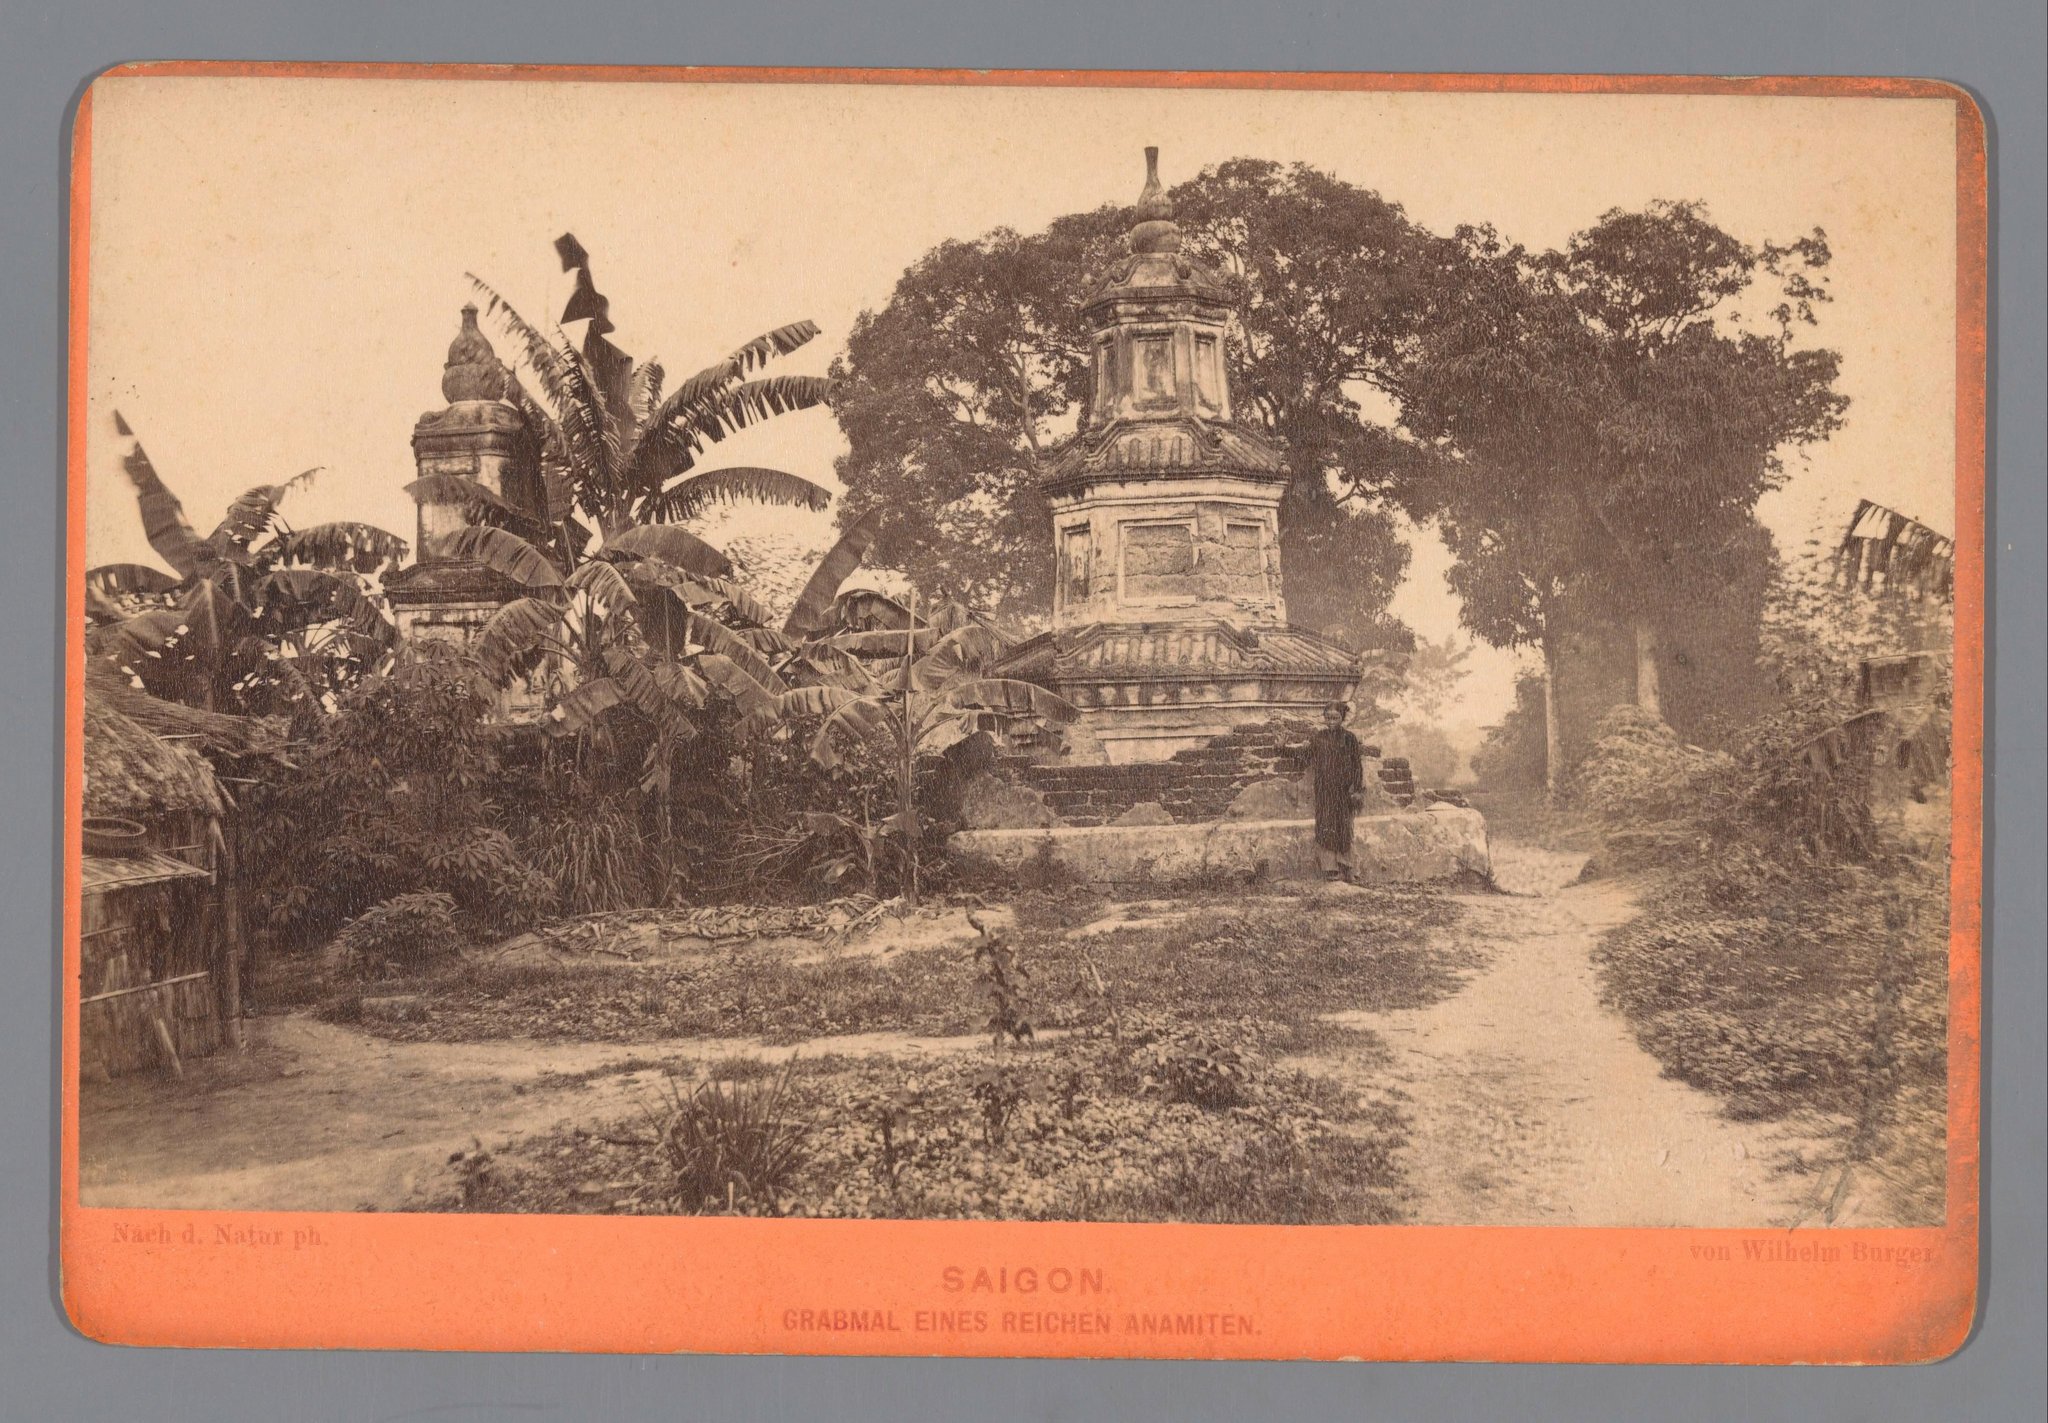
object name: cabinet photograph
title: Saigon. Grabmal Eines Reichen Anamiten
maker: wilhelm burger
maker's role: fotograaf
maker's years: 1844-1920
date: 1860-1890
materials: cardboard, photographic support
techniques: albumen print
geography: ho chi minh city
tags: grave, tomb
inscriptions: name: ‘Wilh. Burger Fotograf der K.K. Ostasiatischen Expedition’, number: ‘No. 148.’